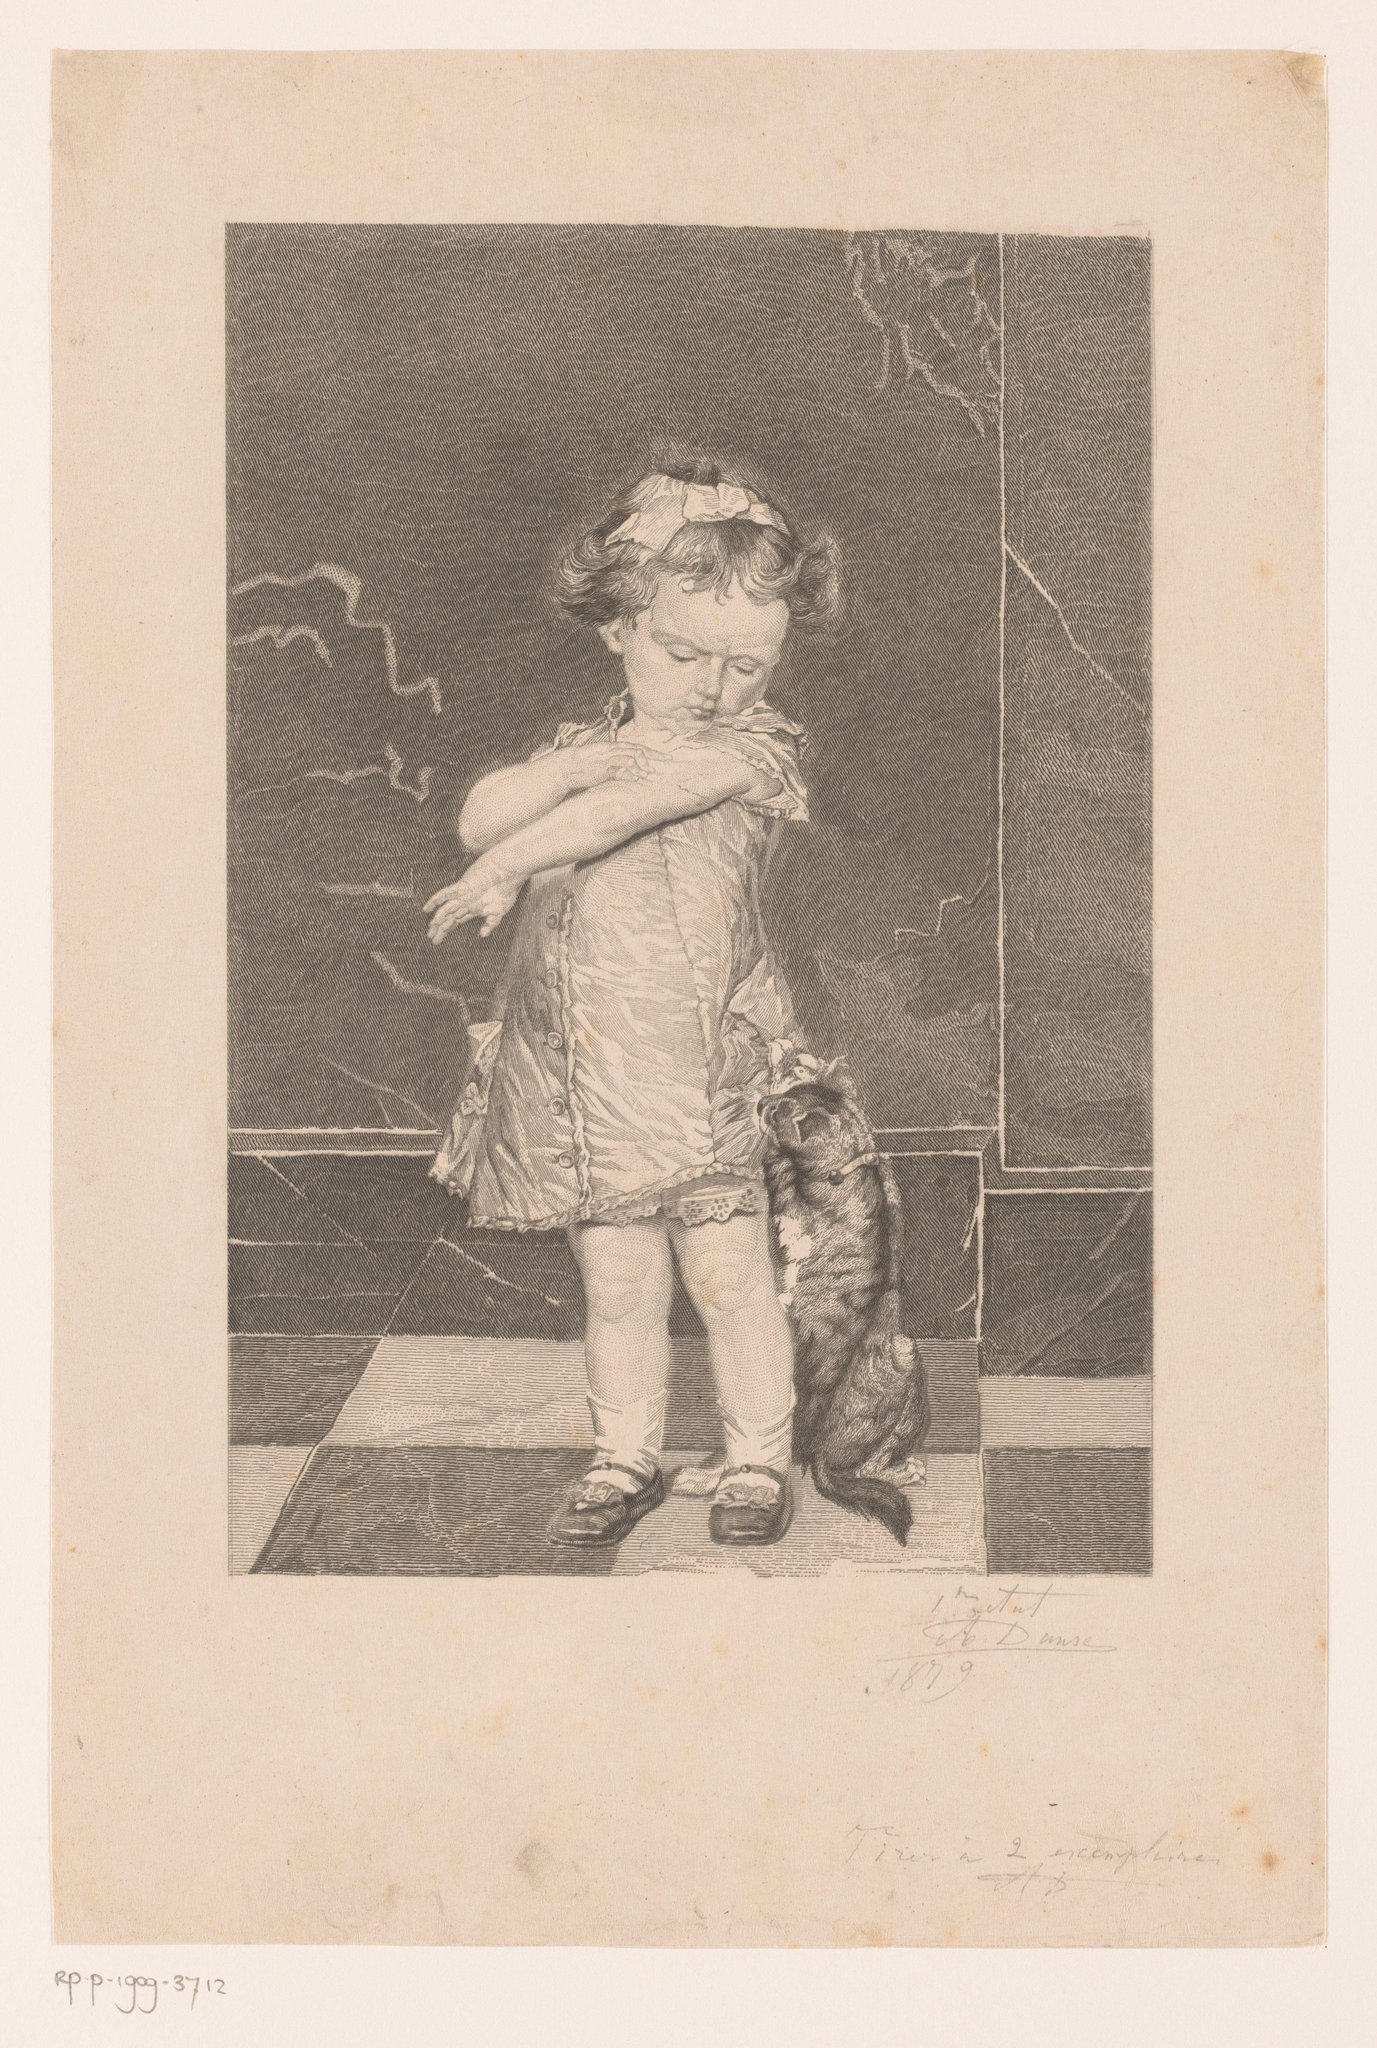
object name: print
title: Meisje inspecteert de kras, die de kat haar op de arm gaf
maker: auguste danse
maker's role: print maker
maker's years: 1829-1929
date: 1879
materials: paper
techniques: etching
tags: cat, girl (child between toddler and youth)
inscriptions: collector's mark: Lugt 2228, annotation: ‘1er etat; Tirer à 2 exemplaires’